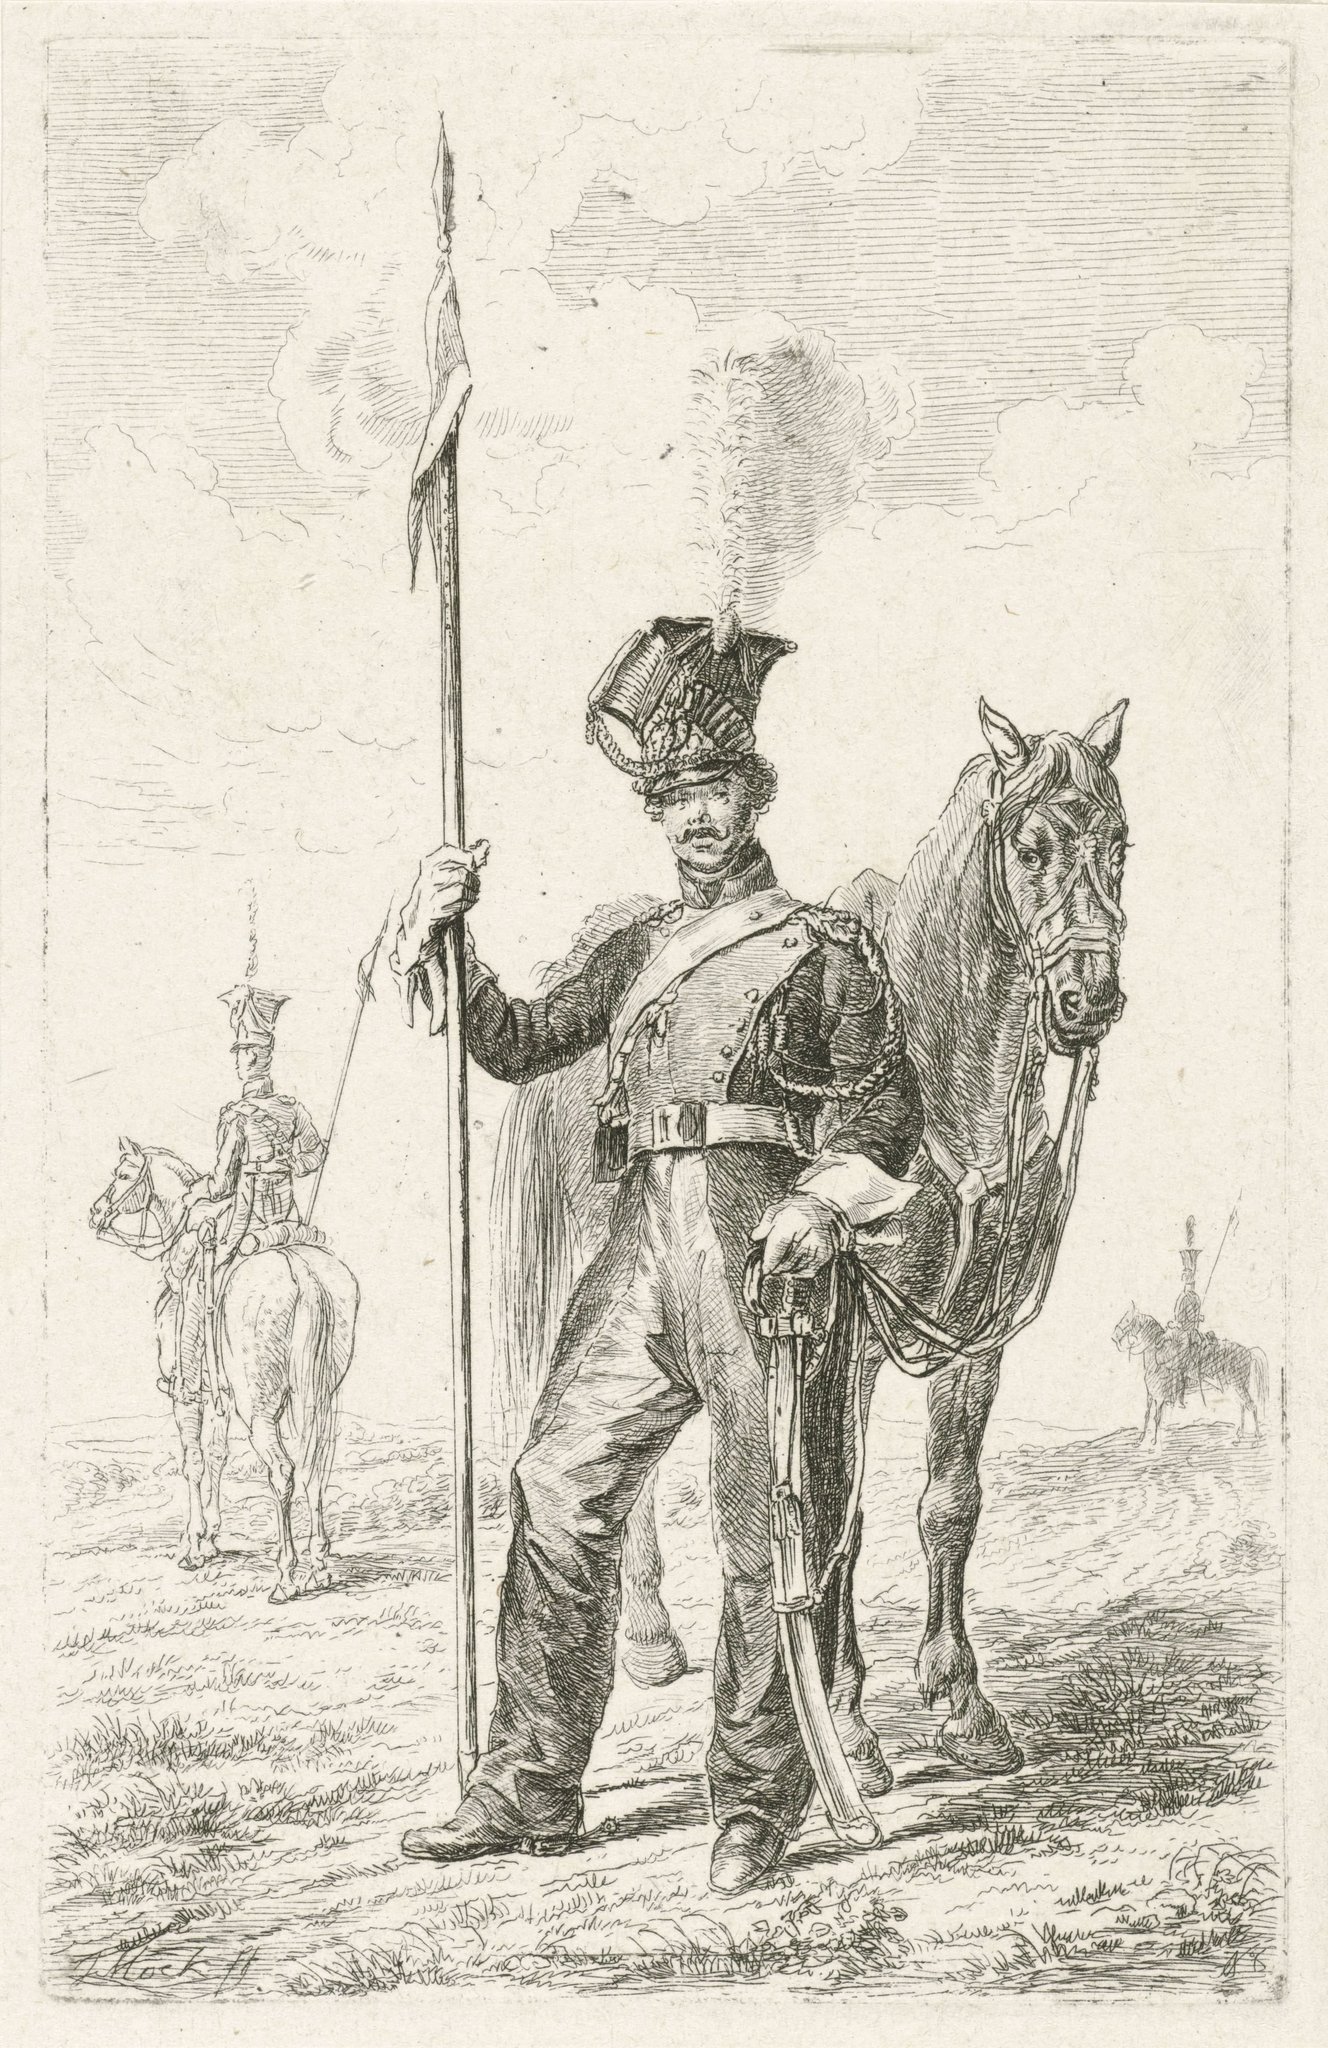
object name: print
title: Soldaat met een lans naast zijn paard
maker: johannes mock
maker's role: draughtsman, painter, print maker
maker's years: 1800-1884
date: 1810-1884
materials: paper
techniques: etching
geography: netherlands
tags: land forces (+ cavalry, horsemen), helved weapons, polearms (for striking, hacking, thrusting): lance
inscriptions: collector's mark: Lugt 2228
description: Soldaat met een lans naast zijn paard. Op de achtergrond twee soldaten te paard.